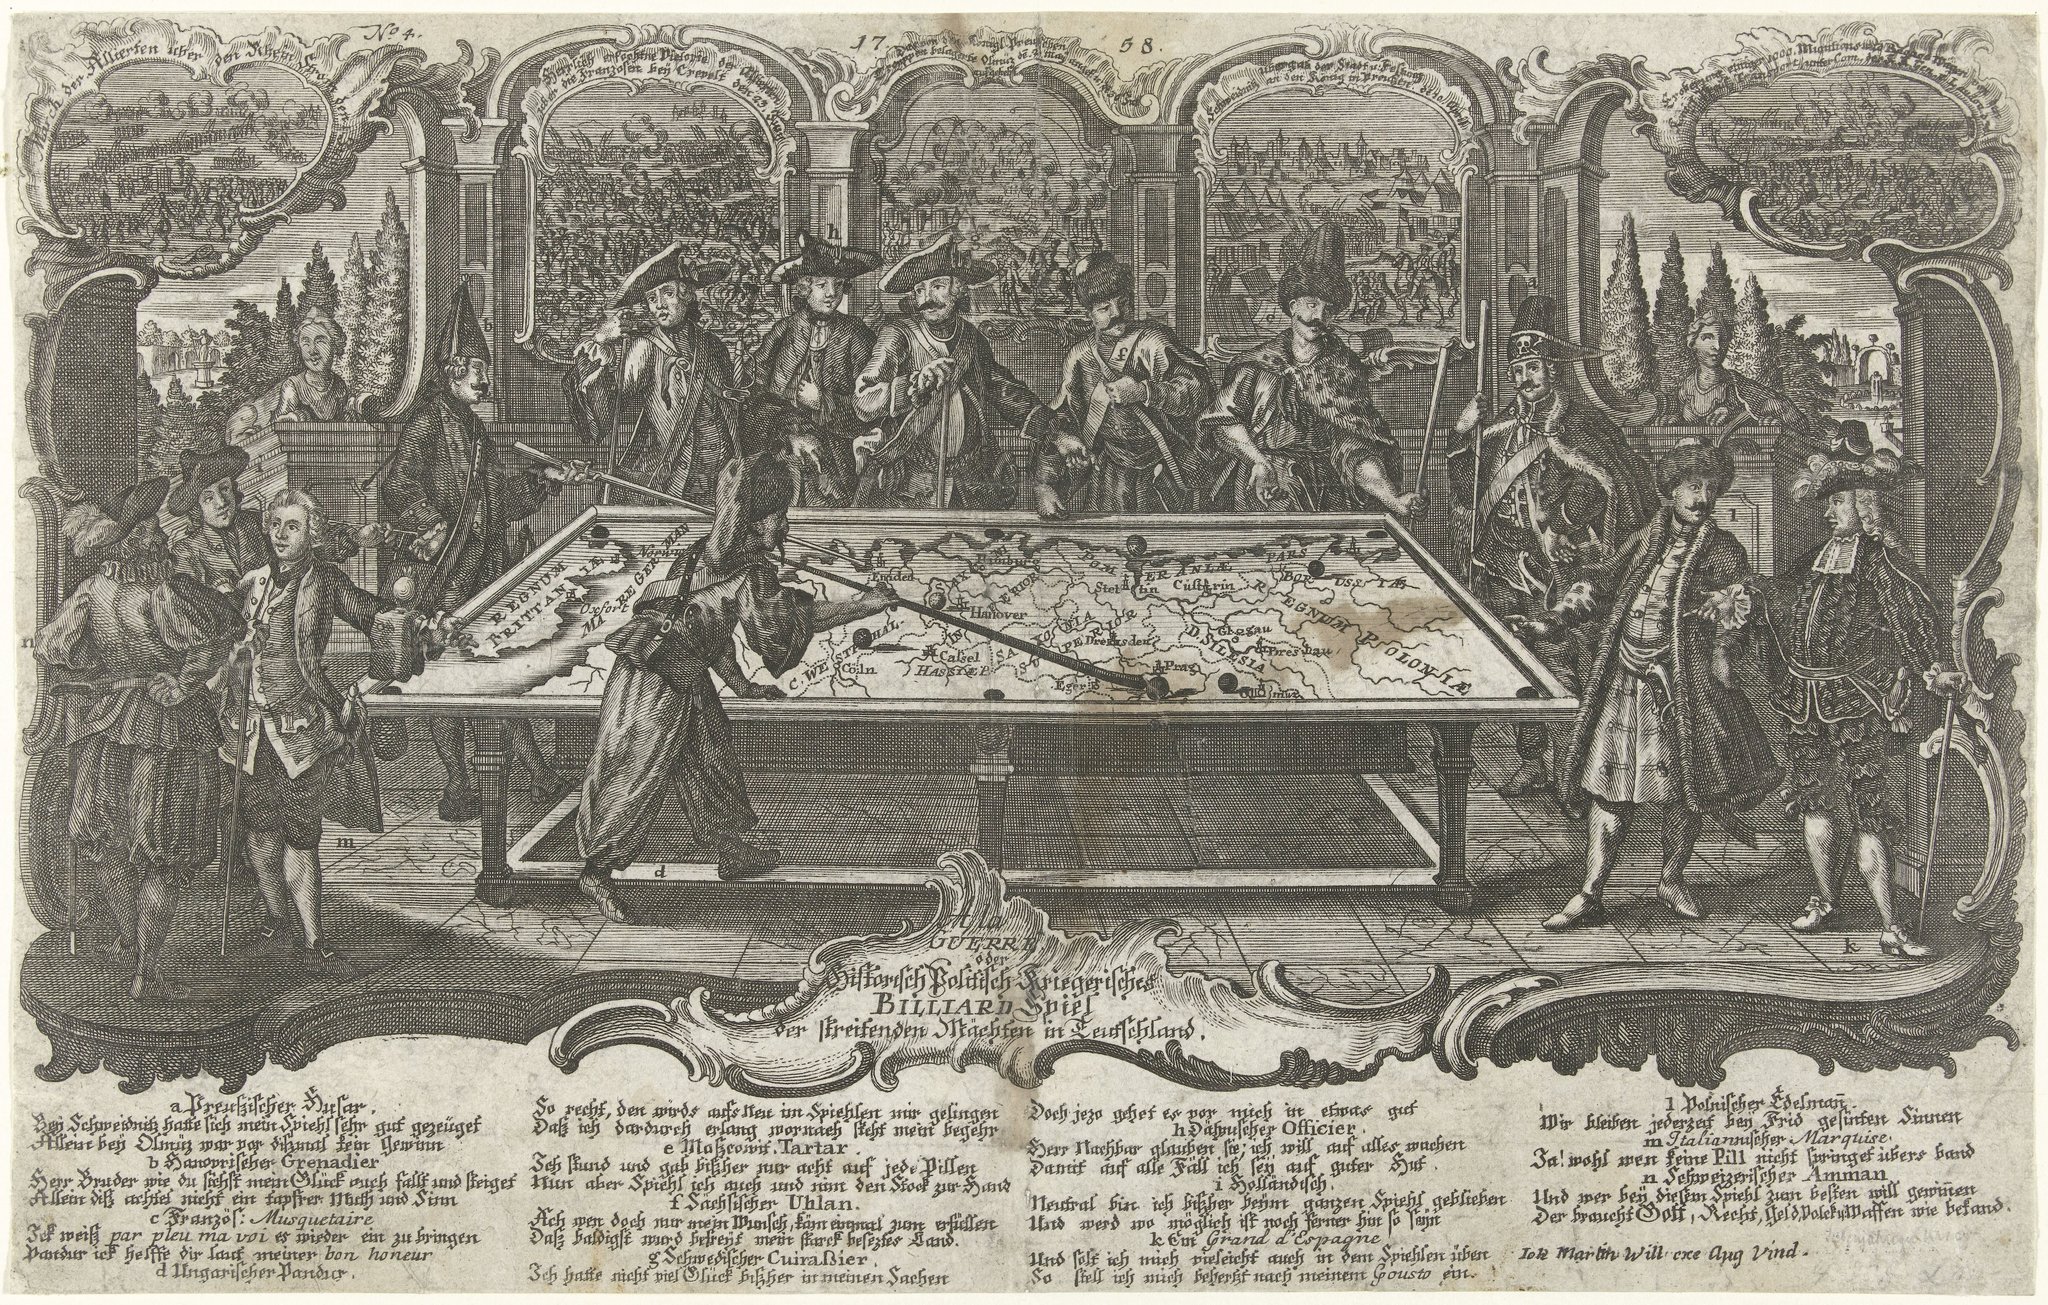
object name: print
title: Politieke biljardspel in Duitsland, 1758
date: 1758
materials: paper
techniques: engraving, etching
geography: augsburg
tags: billiards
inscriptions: collector's mark: Lugt 2228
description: Spotprent waarin de strijdende partijen uit de Zevenjarige Oorlog in het jaar 1758 een potje biljard spelen op de kaart van Oost-Europa. Tot de spelers behoren: Pruisen, Hannover, Frankrijk, Rusland, Saksen, Zweden, Denemarken, Spanje, Polen en Zwitserland. De Nederlander is bij het schouwspel neutraal. Tegen de achterwand bogen met voorstellingen van veldslagen en belegeringen. In het onderschrift spreken de strijdende partijen in het Duits. Genummerd linksboven: No. 4.